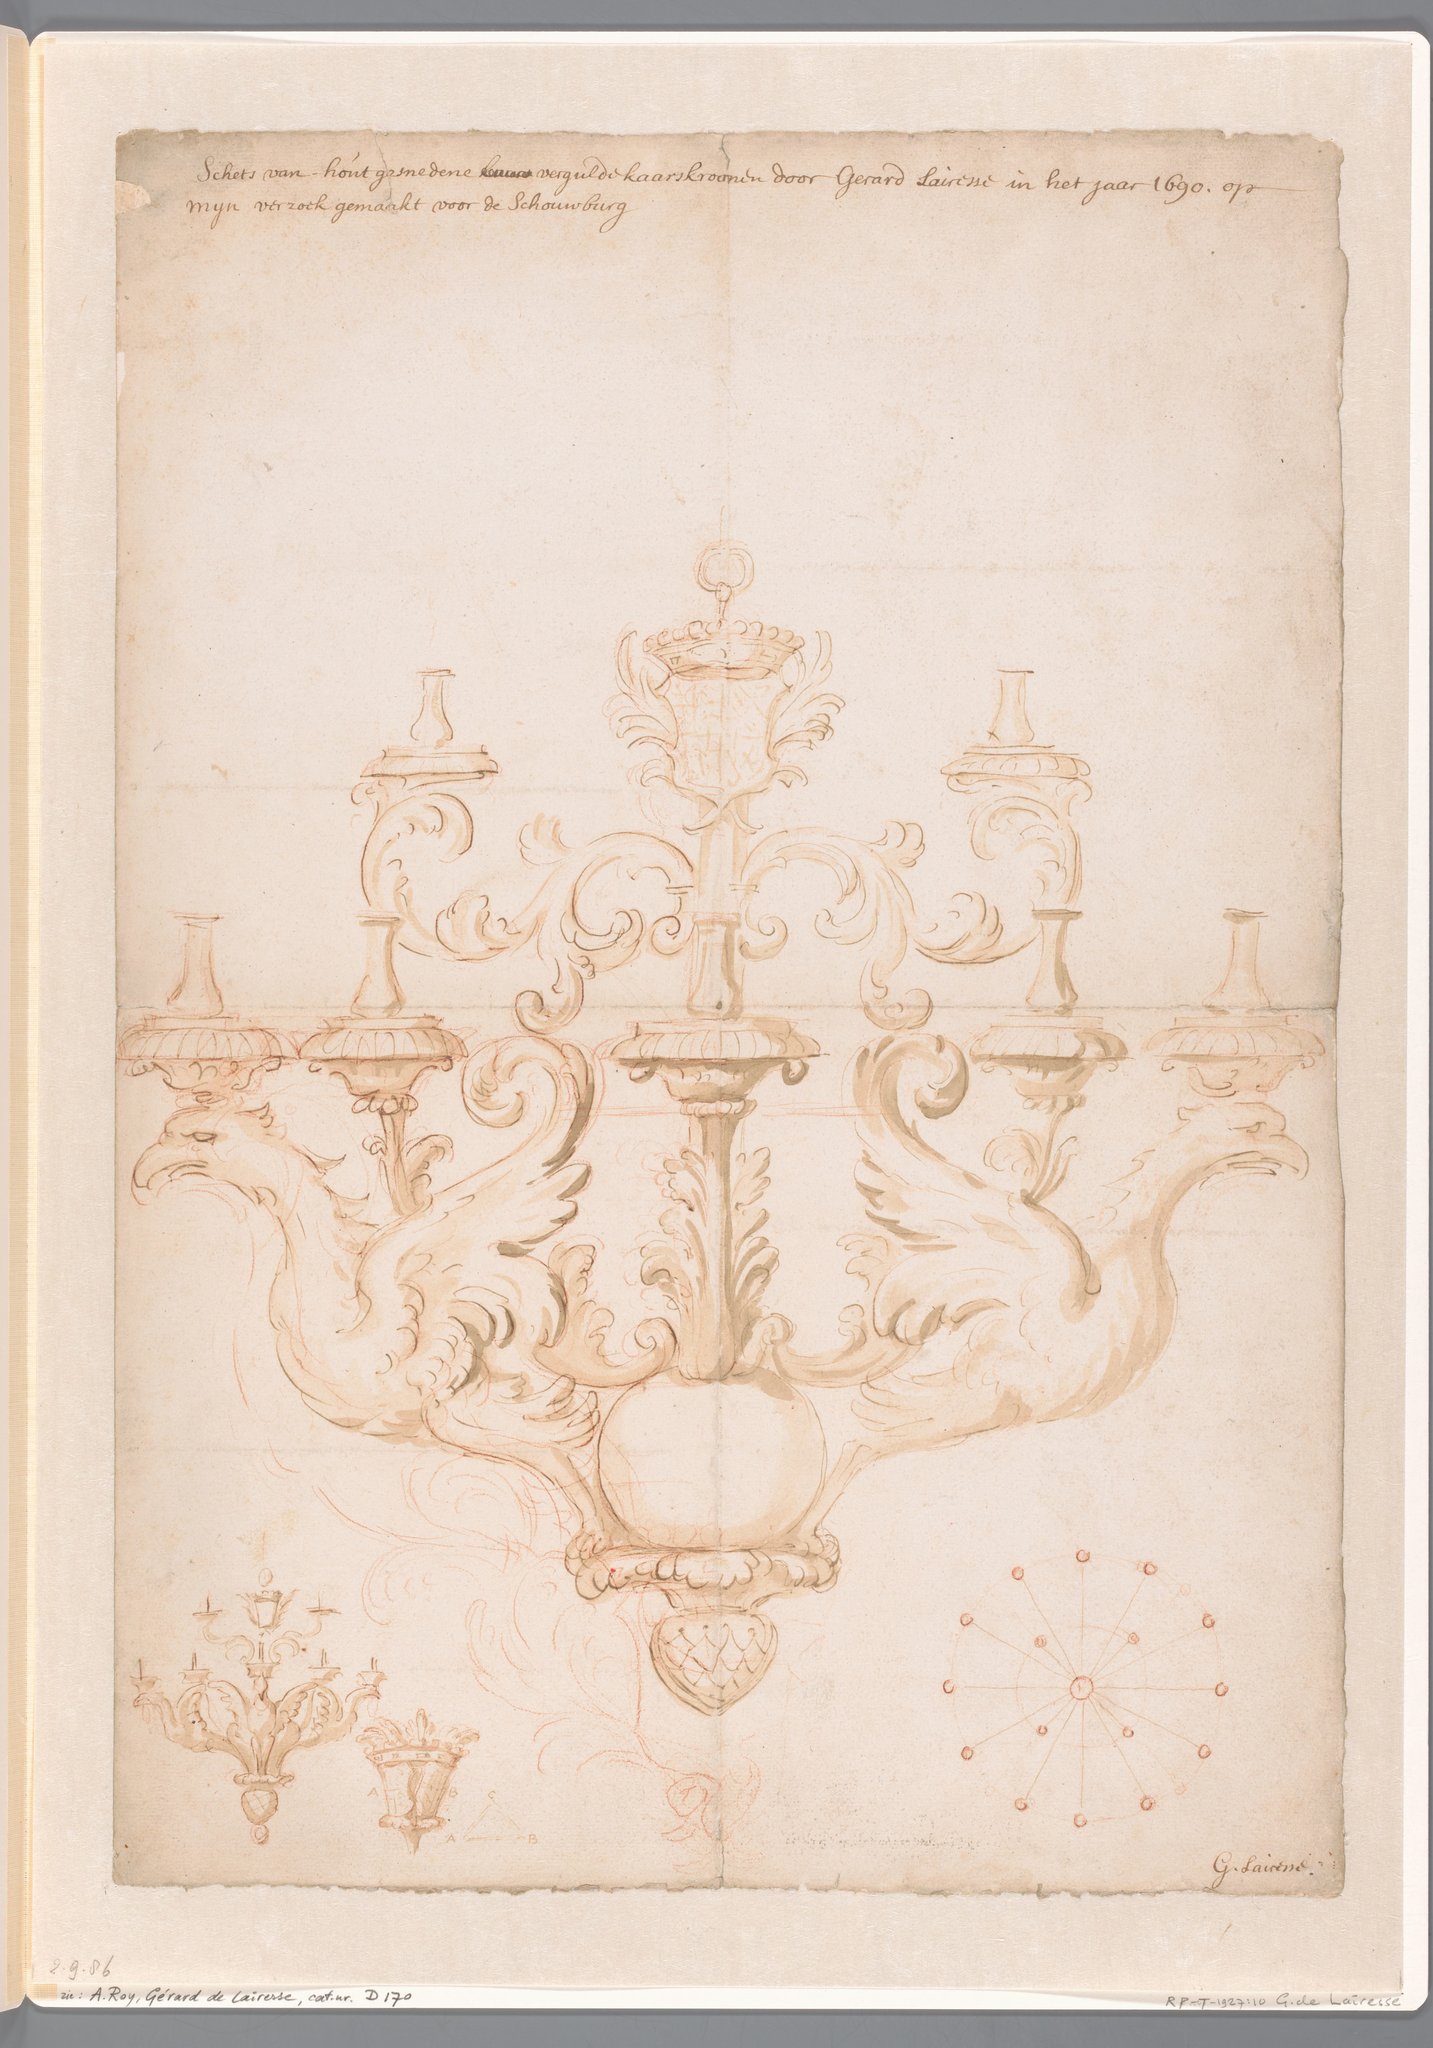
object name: drawing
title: Ontwerp voor een een kroonluchter voor de Amsterdamse Schouwburg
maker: gerard de lairesse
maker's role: draughtsman, painter, print maker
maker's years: 1641-1711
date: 1690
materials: chalk, ink, paper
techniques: brush, pen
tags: chandelier, candelabrum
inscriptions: : ‘Schets van houtgesnedene vergulde kaarskroonen door Gerard Lairesse in het jaar 1690 op myn verzoek gemaakt voor de Schouwburg’